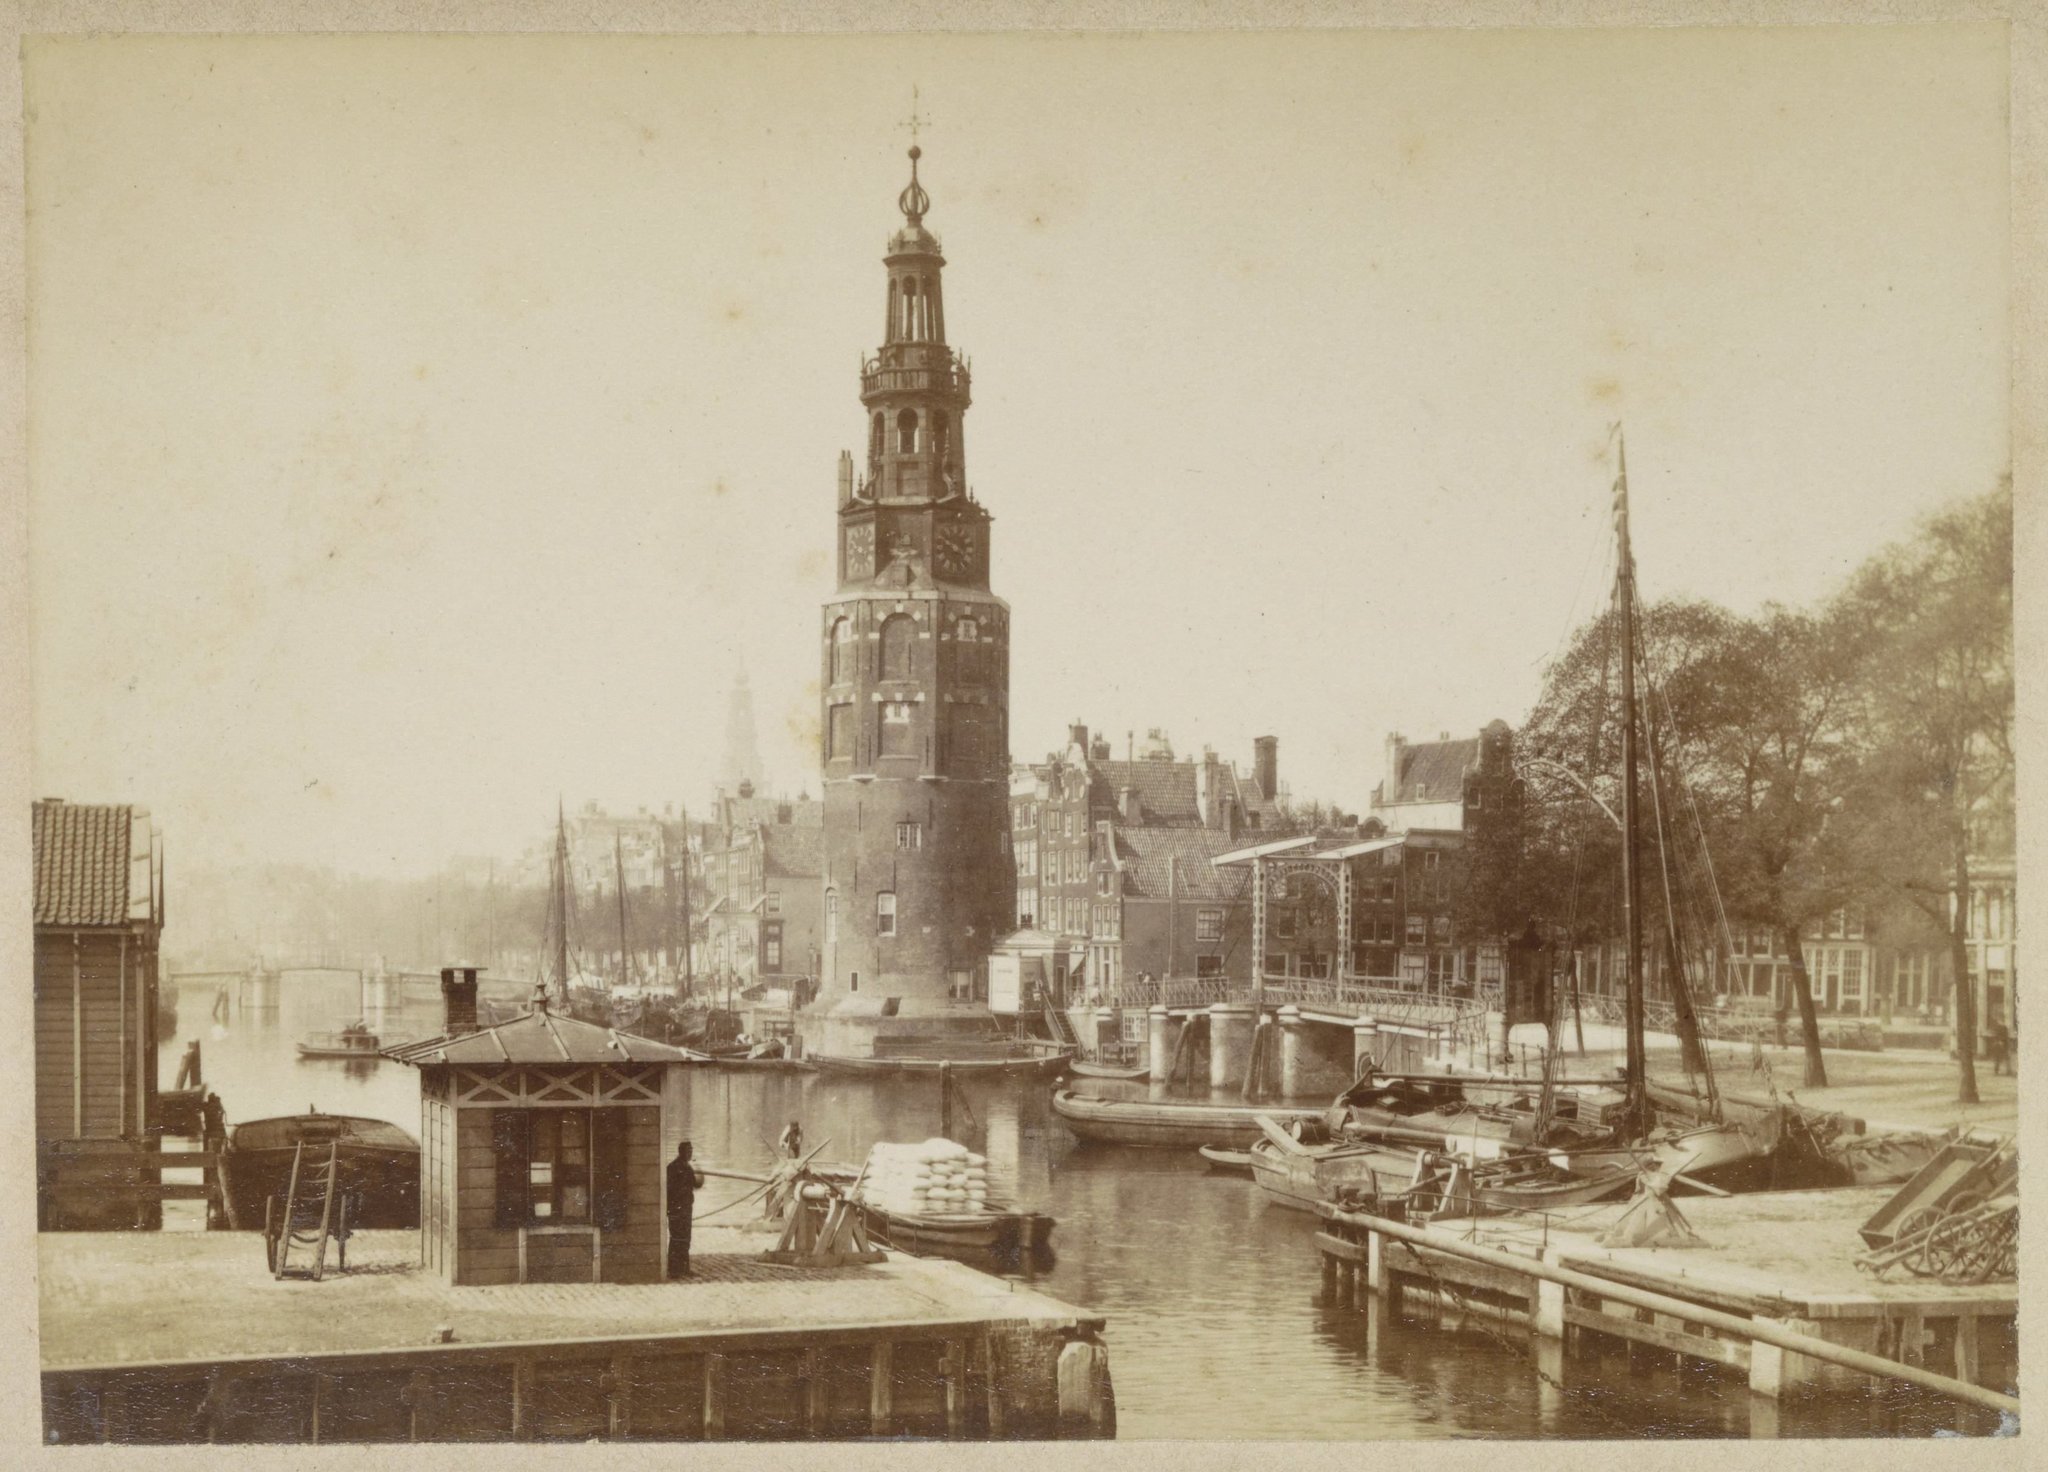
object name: photograph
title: Gezicht op de Oude Schans en de Montelbaanstoren met op de voorgrond de Kikkerbilsluis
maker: andries jager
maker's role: publisher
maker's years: 1825-1905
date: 1860-1900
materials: cardboard, photographic support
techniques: albumen print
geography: amsterdam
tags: sluice, weir, hand-cart, towers ~ fortified city, canals, waters (in city)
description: Onderdeel van Leporelloalbum met 12 foto's van Amsterdam.